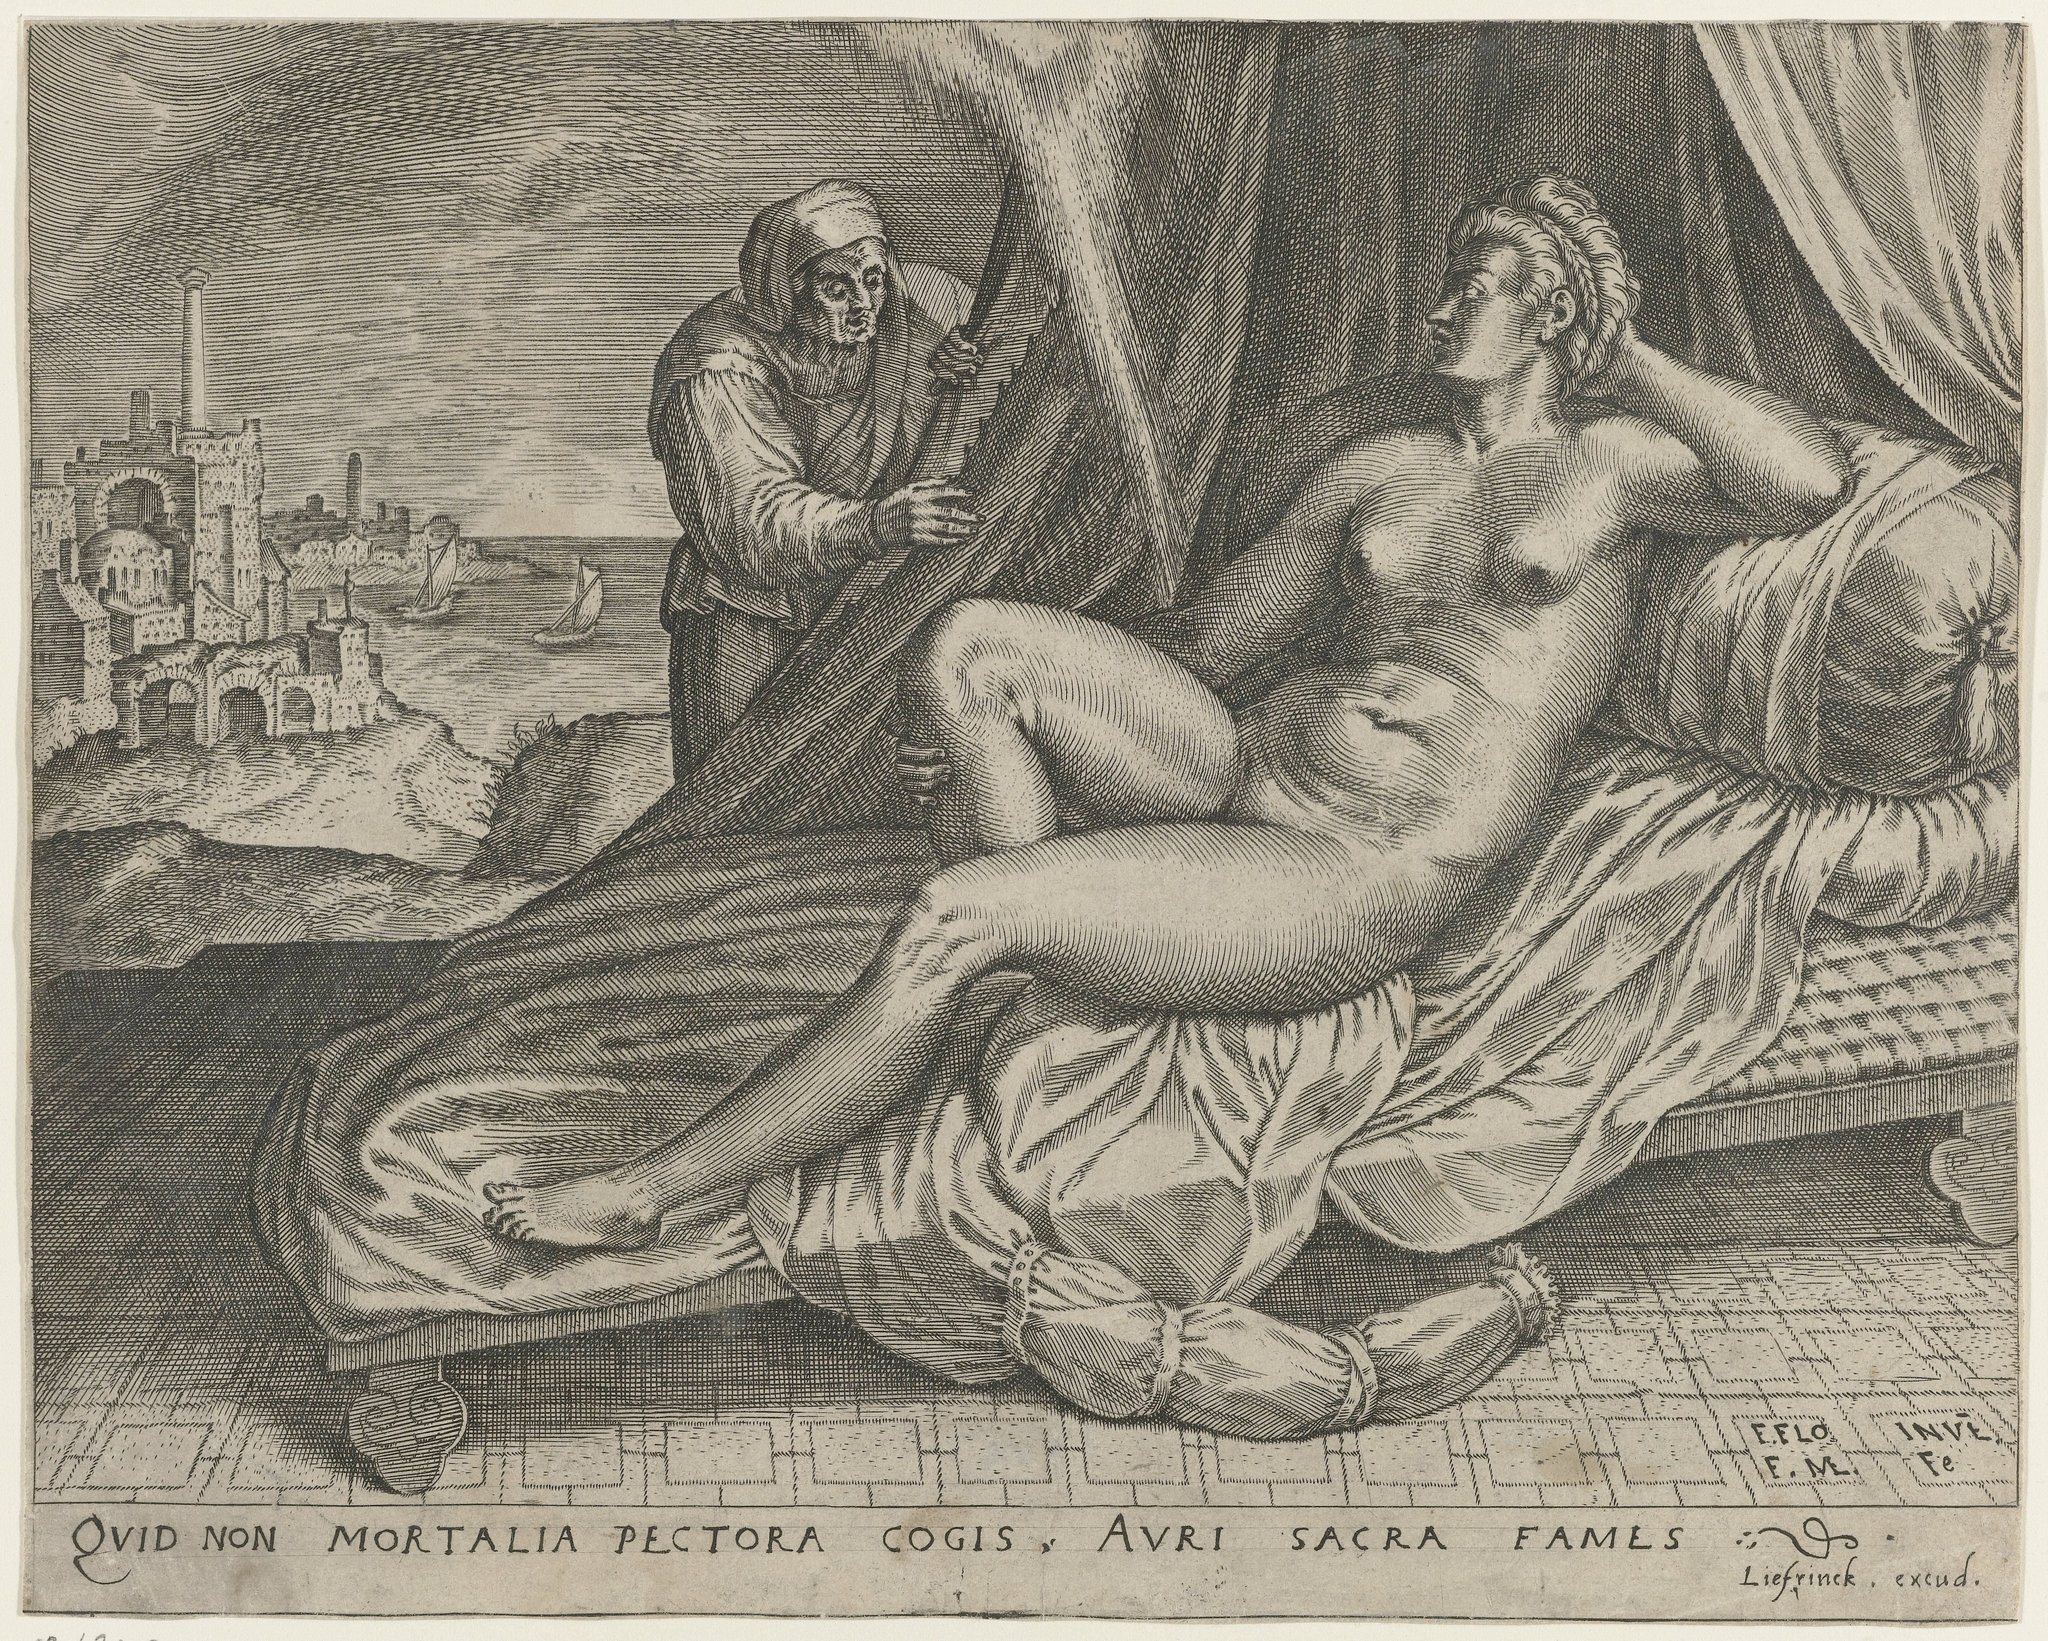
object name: print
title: Jupiter en Danaë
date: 1538-1599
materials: paper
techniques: engraving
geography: low countries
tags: jupiter wooing danae; she is usually lying in bed receiving a shower of gold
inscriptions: collector's mark: Lugt 2228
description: Jupiter daalt op Danaë neer in de vorm van gouden regen of licht, terwijl ze op een rustbank ligt. Haar oude dienares kijkt toe vanachter een gordijn. In de verte een gezicht op Argos. Onder in de marge een éénregelig onderschrift in het Latijn.